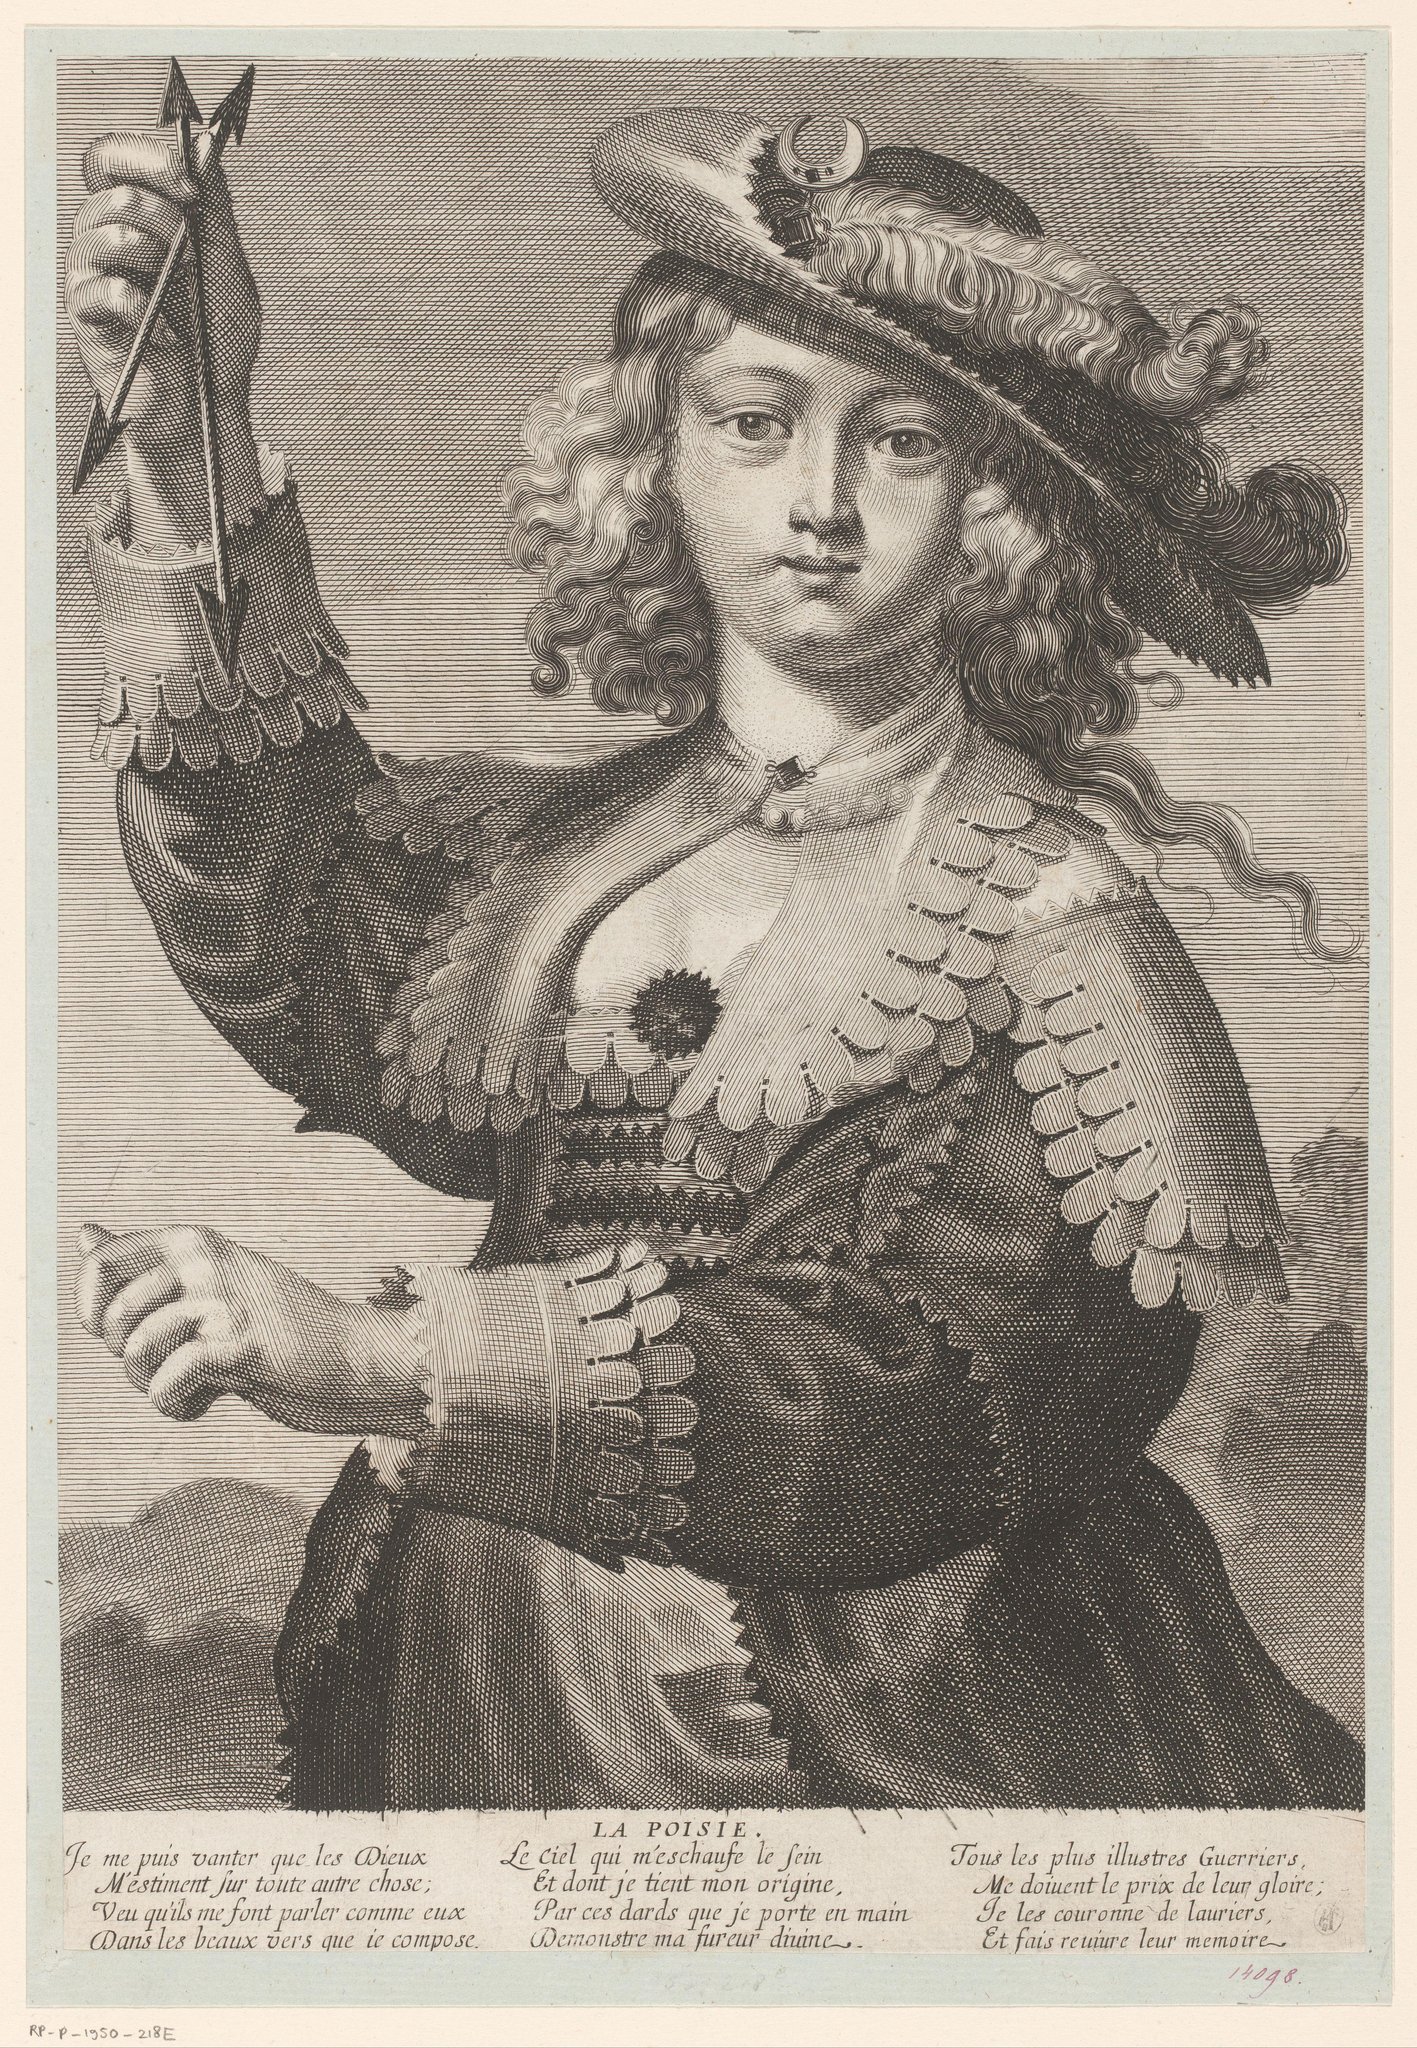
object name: print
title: Poesia (Poëzie)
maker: jean baptiste humbelot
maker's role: print maker, publisher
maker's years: 1600-1685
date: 1600-1685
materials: paper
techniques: engraving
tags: symbolic representations, allegories and emblems ~ poetry; 'poesia' (ripa)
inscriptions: number: ‘14098.’, collector's mark: Lugt 2228, collector's mark: Lugt 971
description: Maakt deel uit van een serie met personificaties van de vrije kunsten.